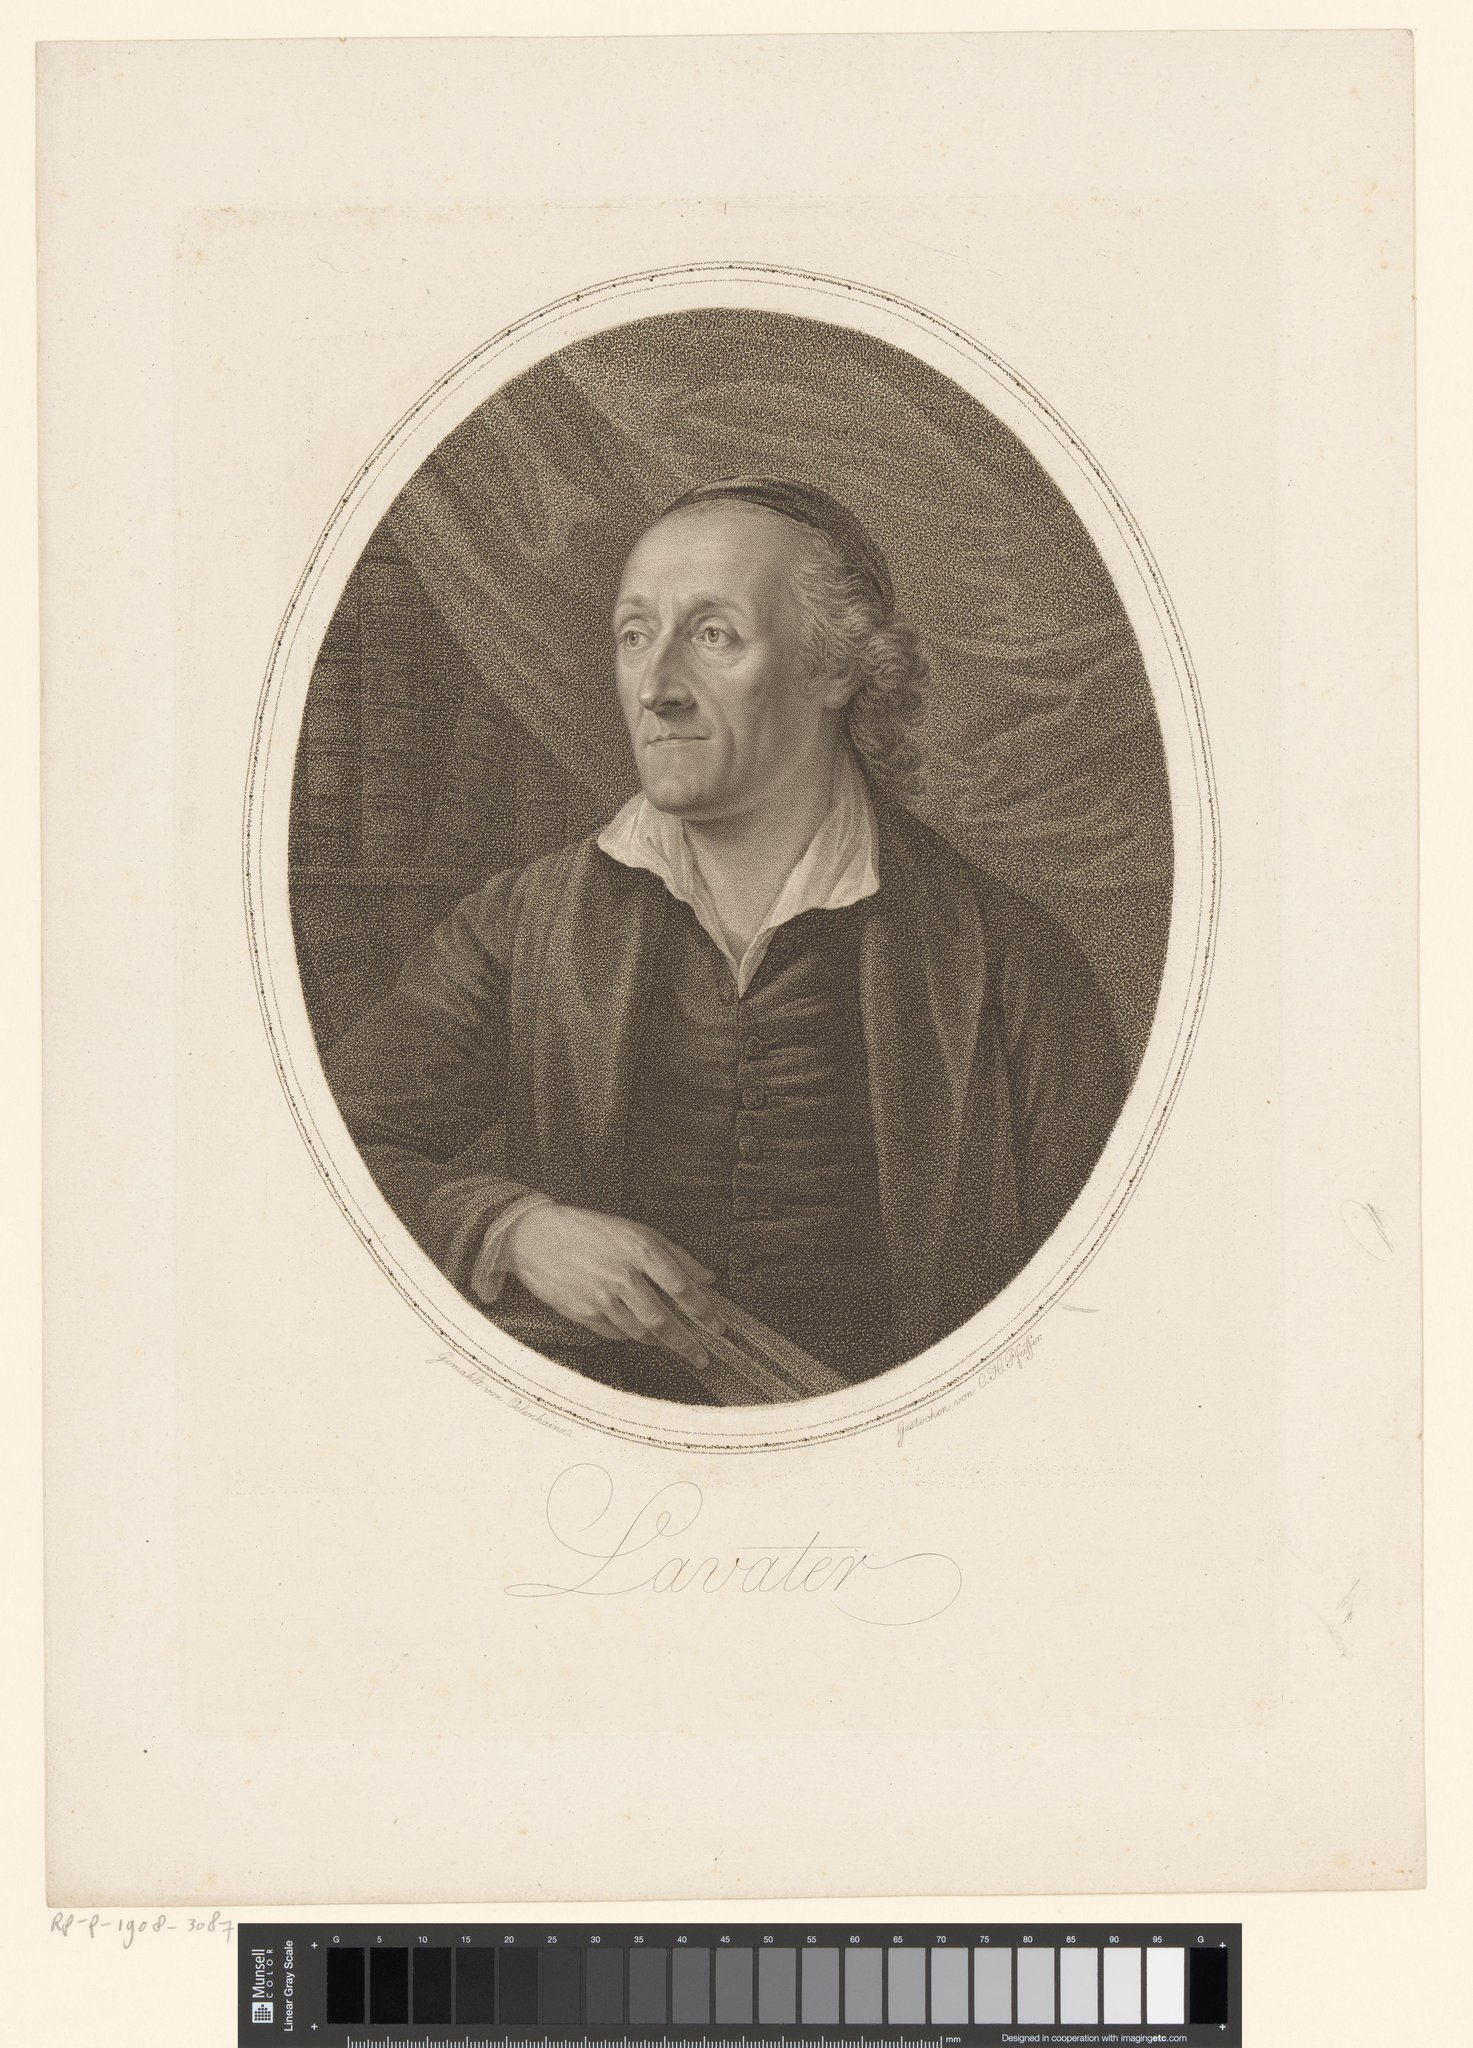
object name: print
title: Portret van Johann Kaspar Lavater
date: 1779-1800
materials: paper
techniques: engraving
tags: johann caspar lavater, bookshelves, historical persons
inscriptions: collector's mark: Lugt 2228, mark: Lugt 994